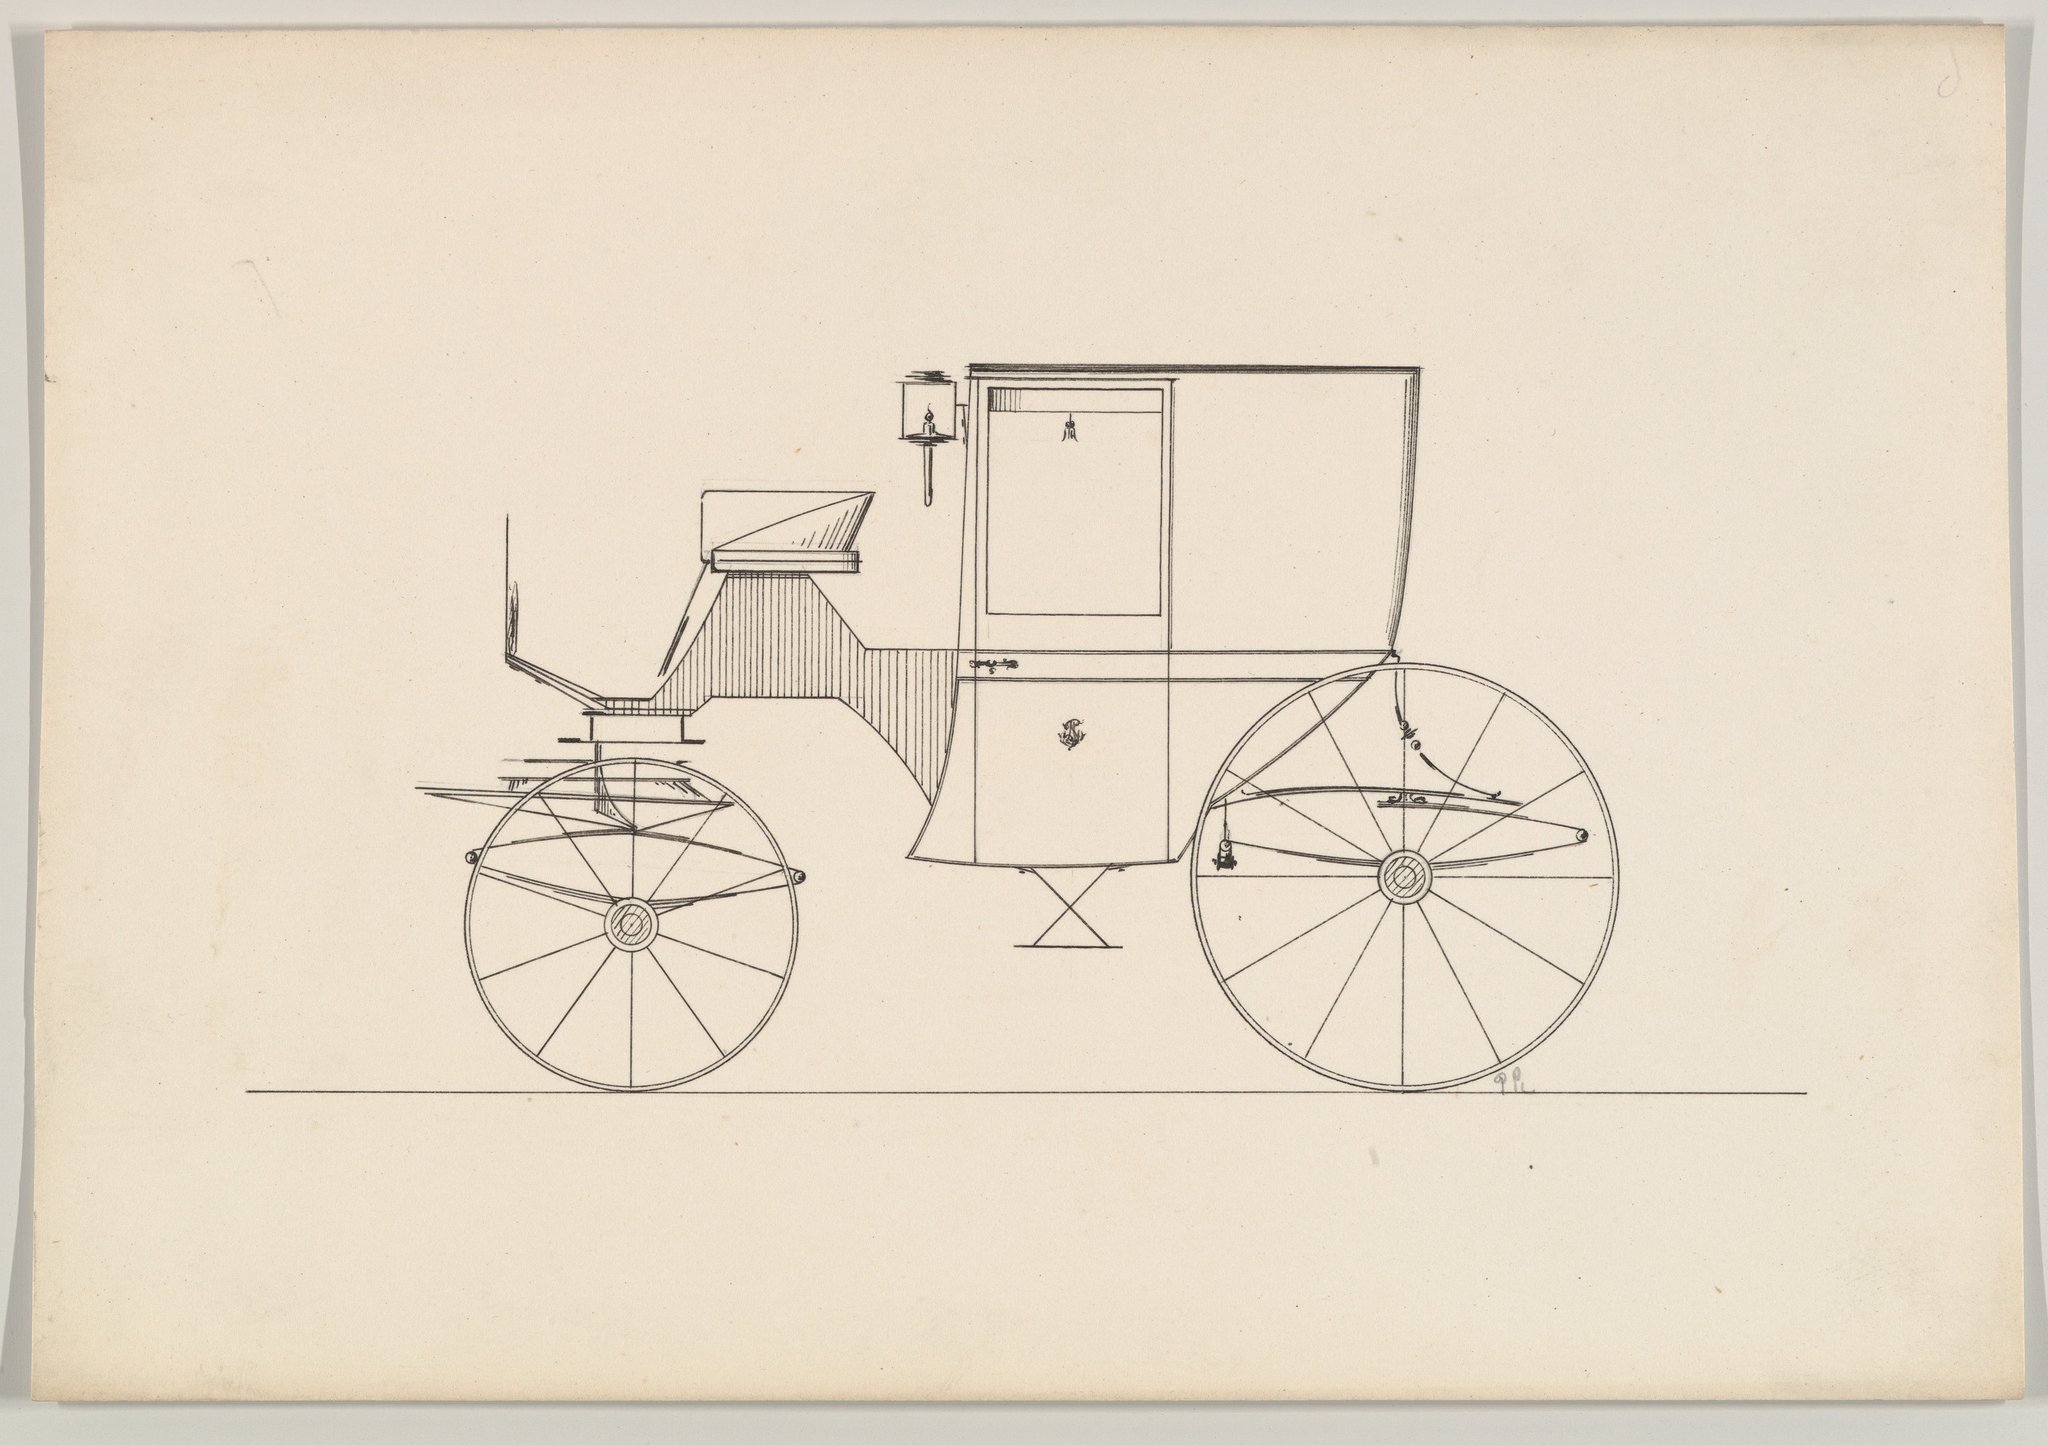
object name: drawing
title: Coupe or Brougham (unnumbered)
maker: brewster & co.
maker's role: manufacturer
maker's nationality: american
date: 1850-1870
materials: graphite, ink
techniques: pen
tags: carriages